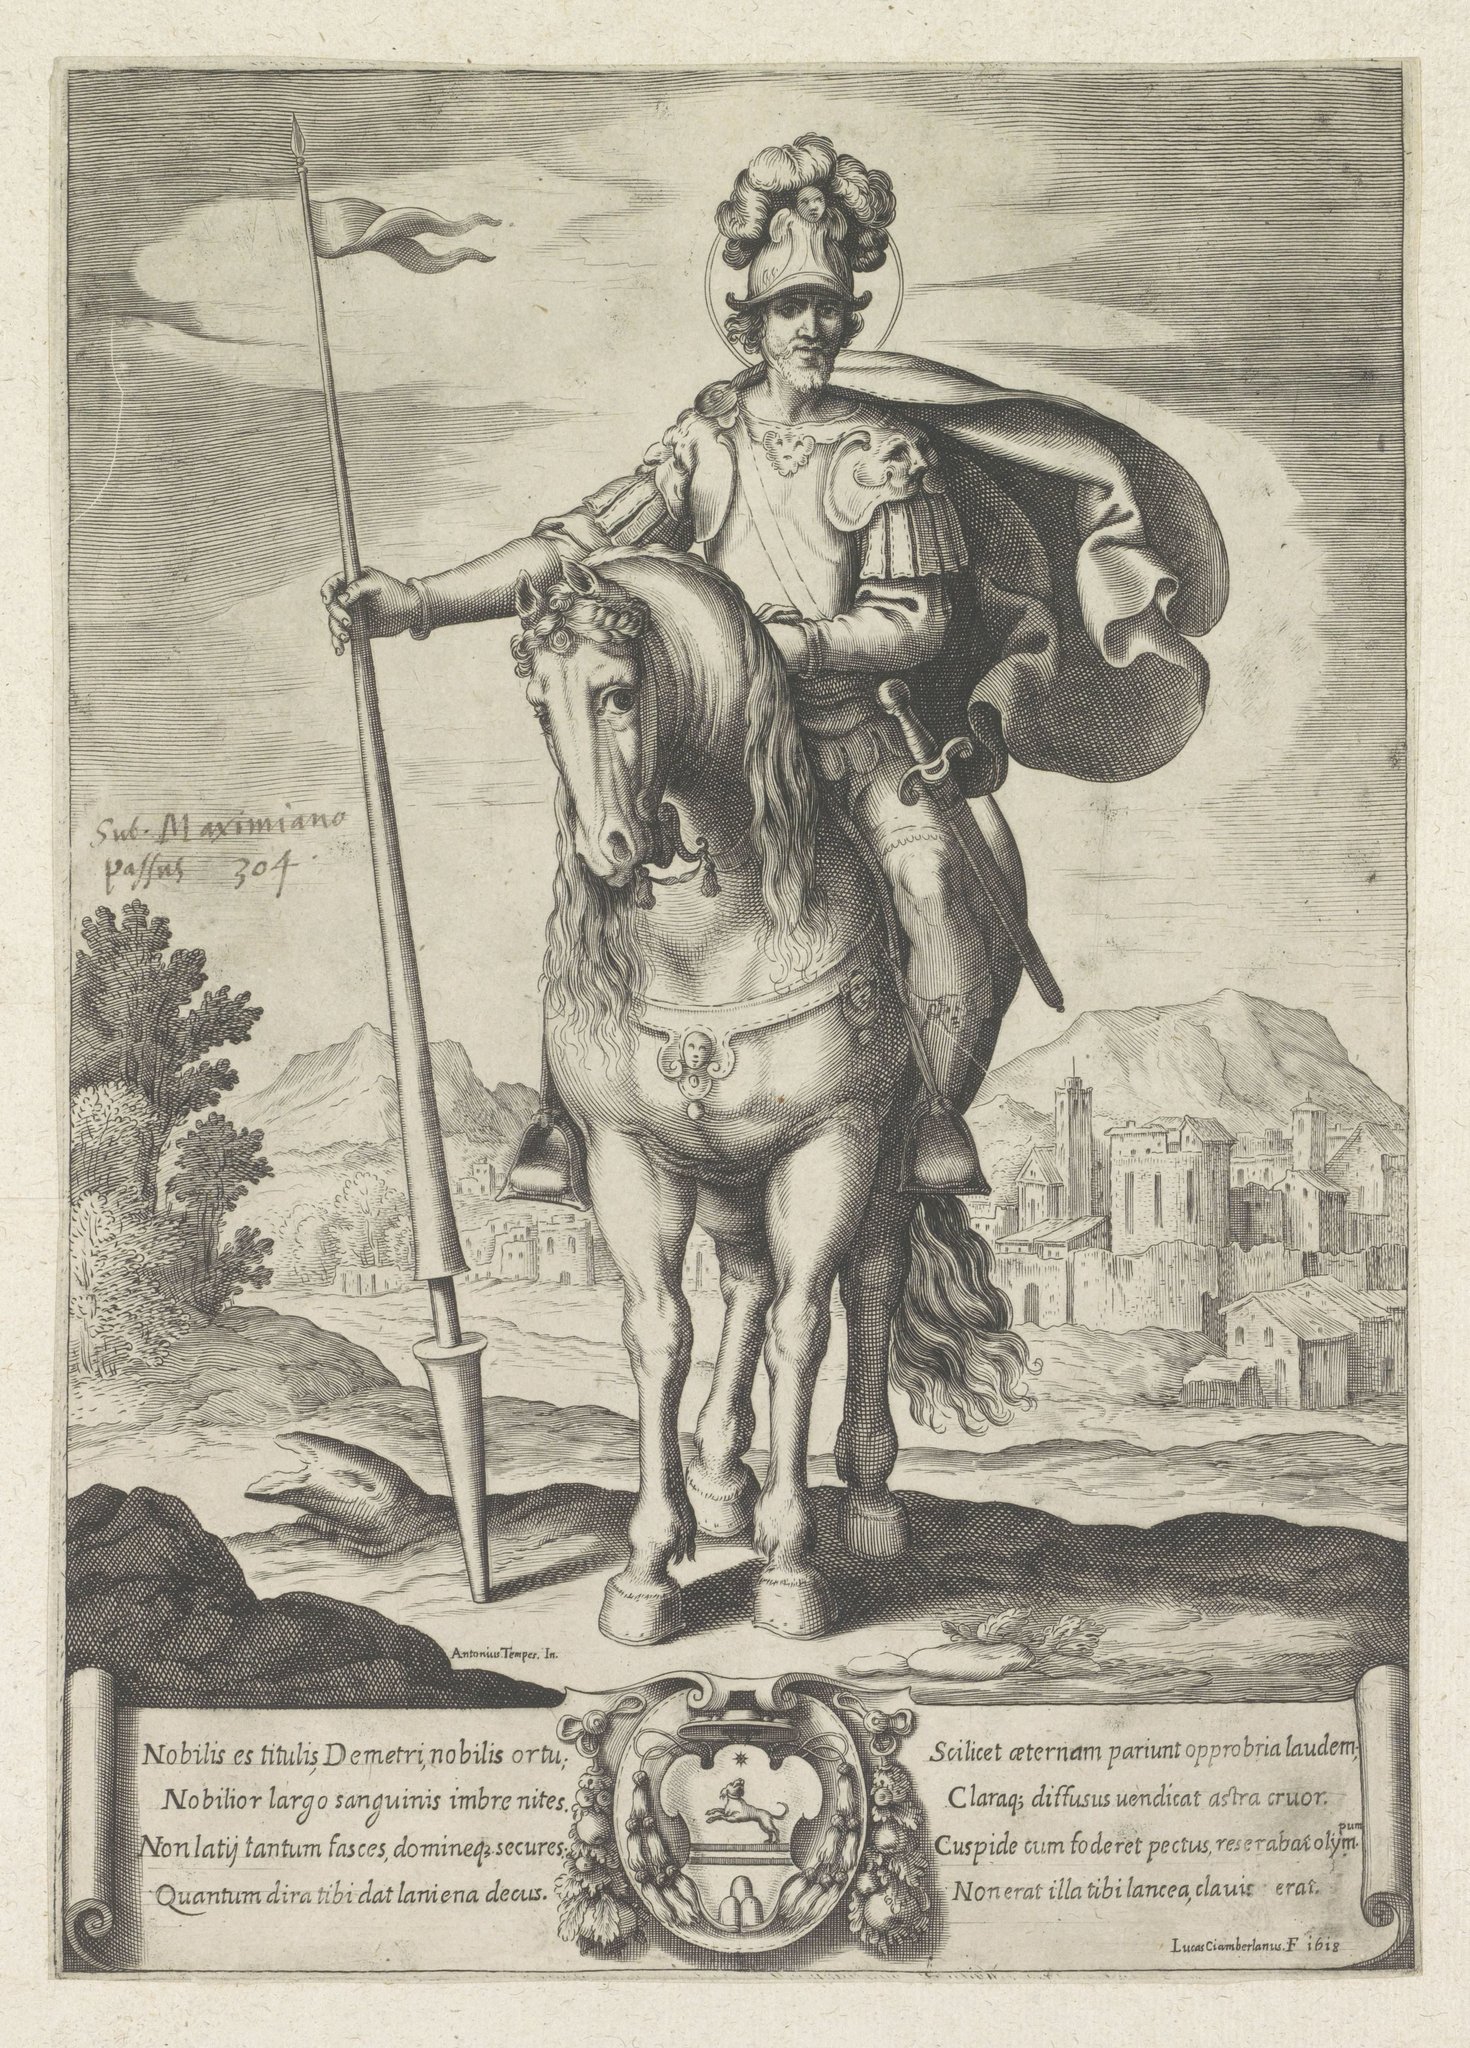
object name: print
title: Soldaat te paard met lans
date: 1618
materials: paper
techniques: engraving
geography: italy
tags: riding a horse, ass, or mule; rider, horseman, helved weapons, polearms (for striking, hacking, thrusting): lance, warfare; military affairs (+ cavalry, horsemen)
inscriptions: inscription: ‘Sub. Maximiano / Passus 304’, collector's mark: Lugt 240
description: Een soldaat te paard met een lans in zijn hand. Op de achtergrond een stad in een landschap. Tekst en wapenschild in ondermarge.